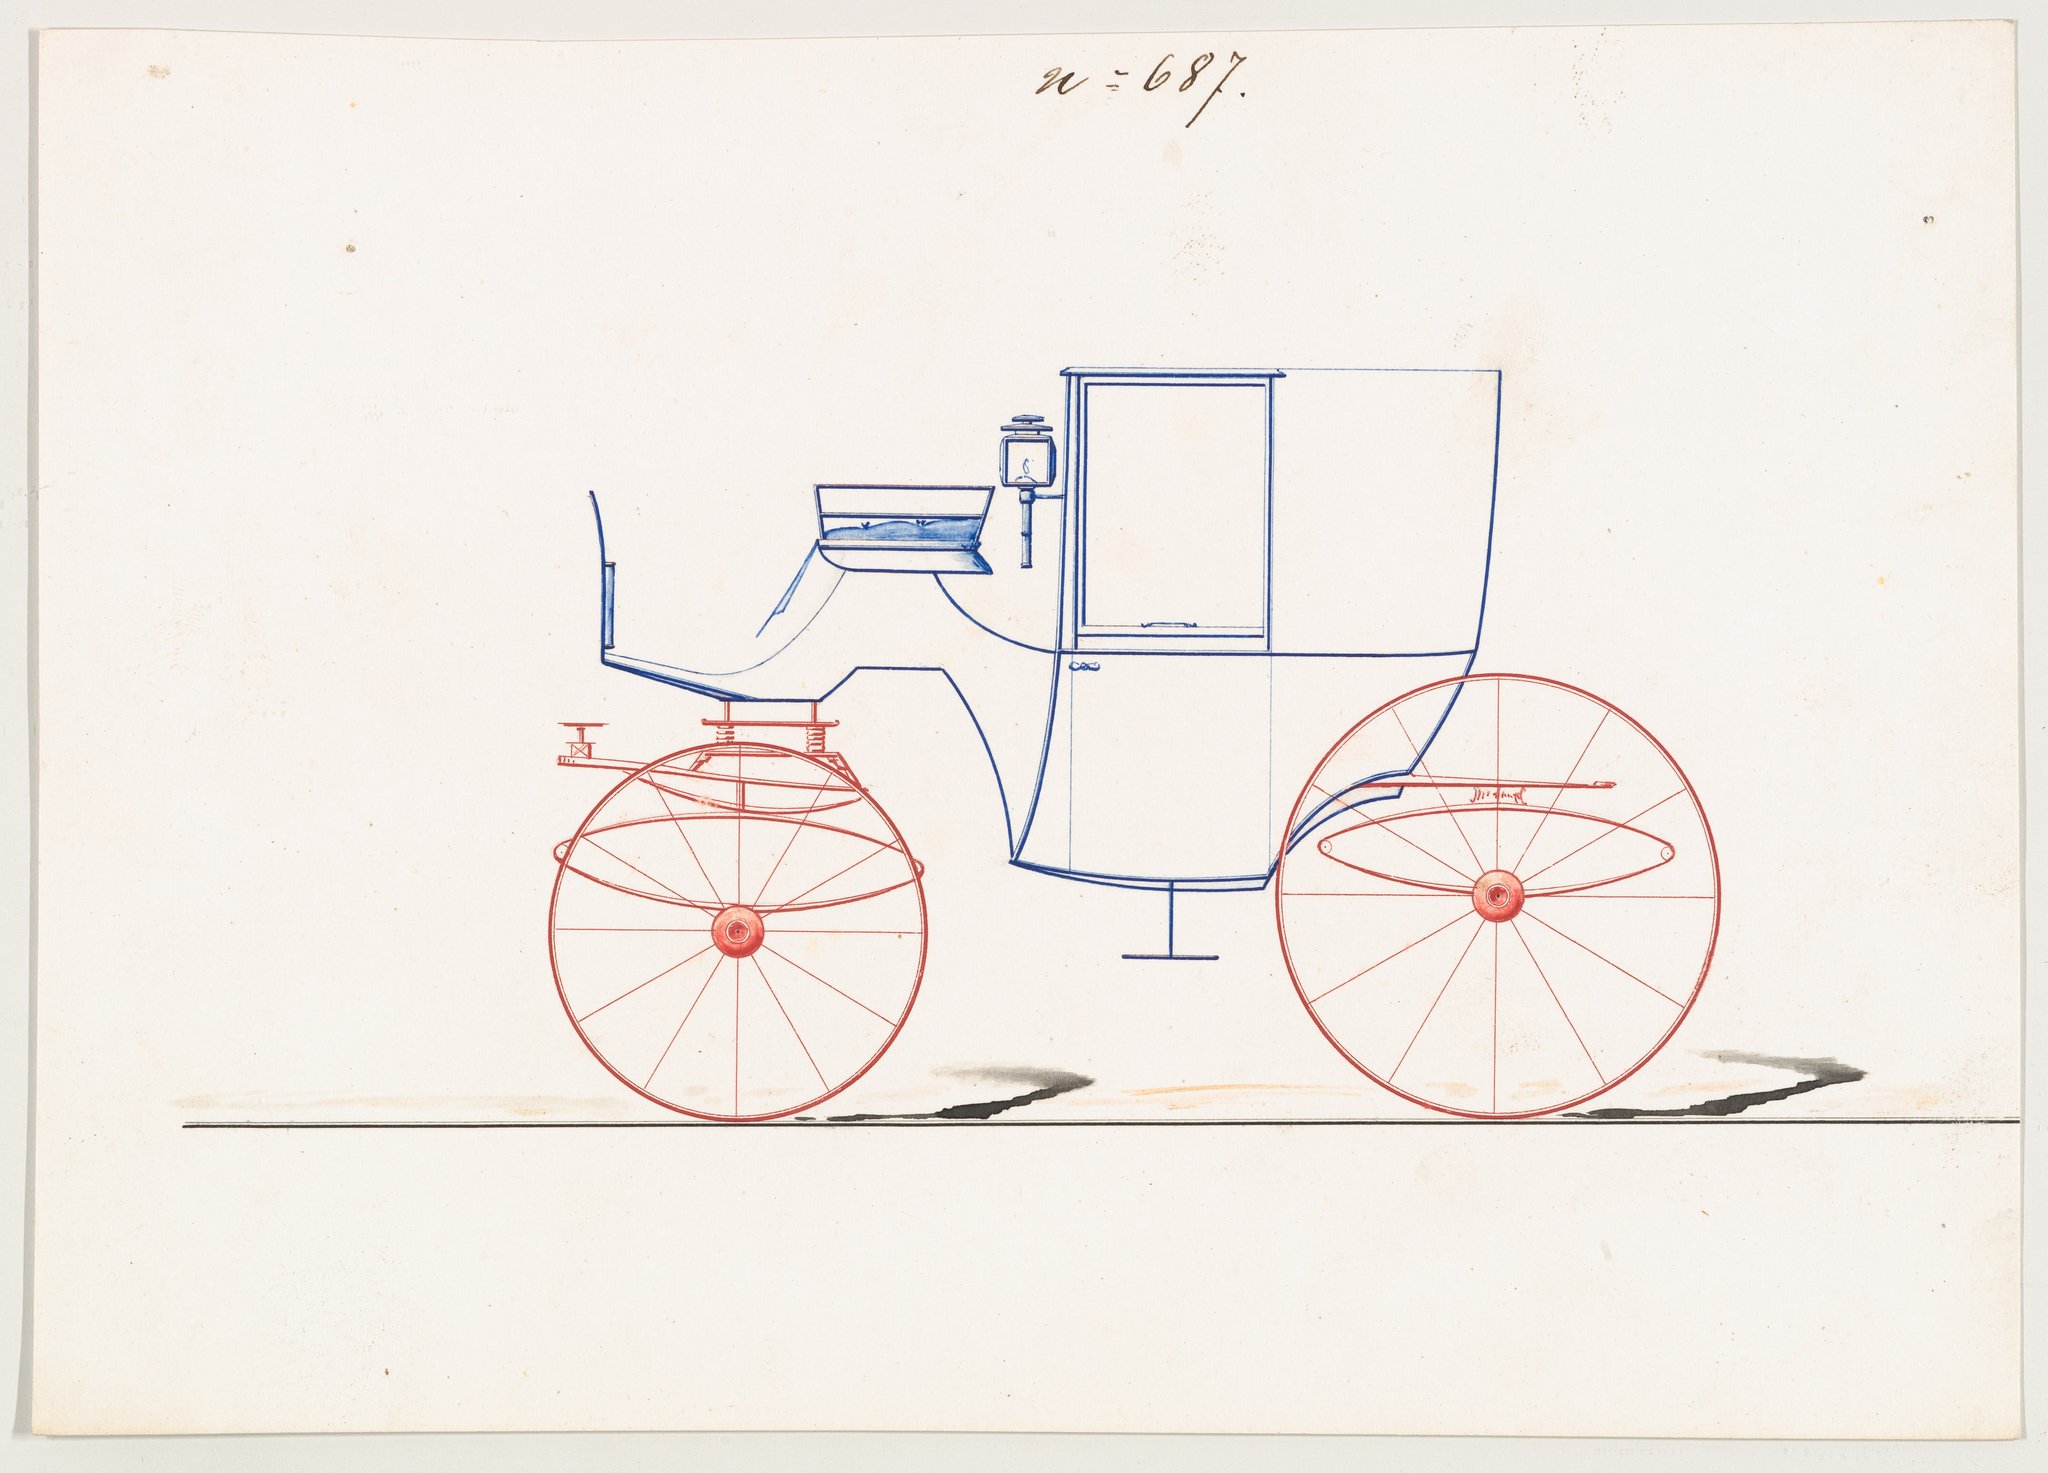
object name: drawing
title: Coupe #687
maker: brewster & co.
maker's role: manufacturer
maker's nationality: american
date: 1860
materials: watercolor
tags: carriages